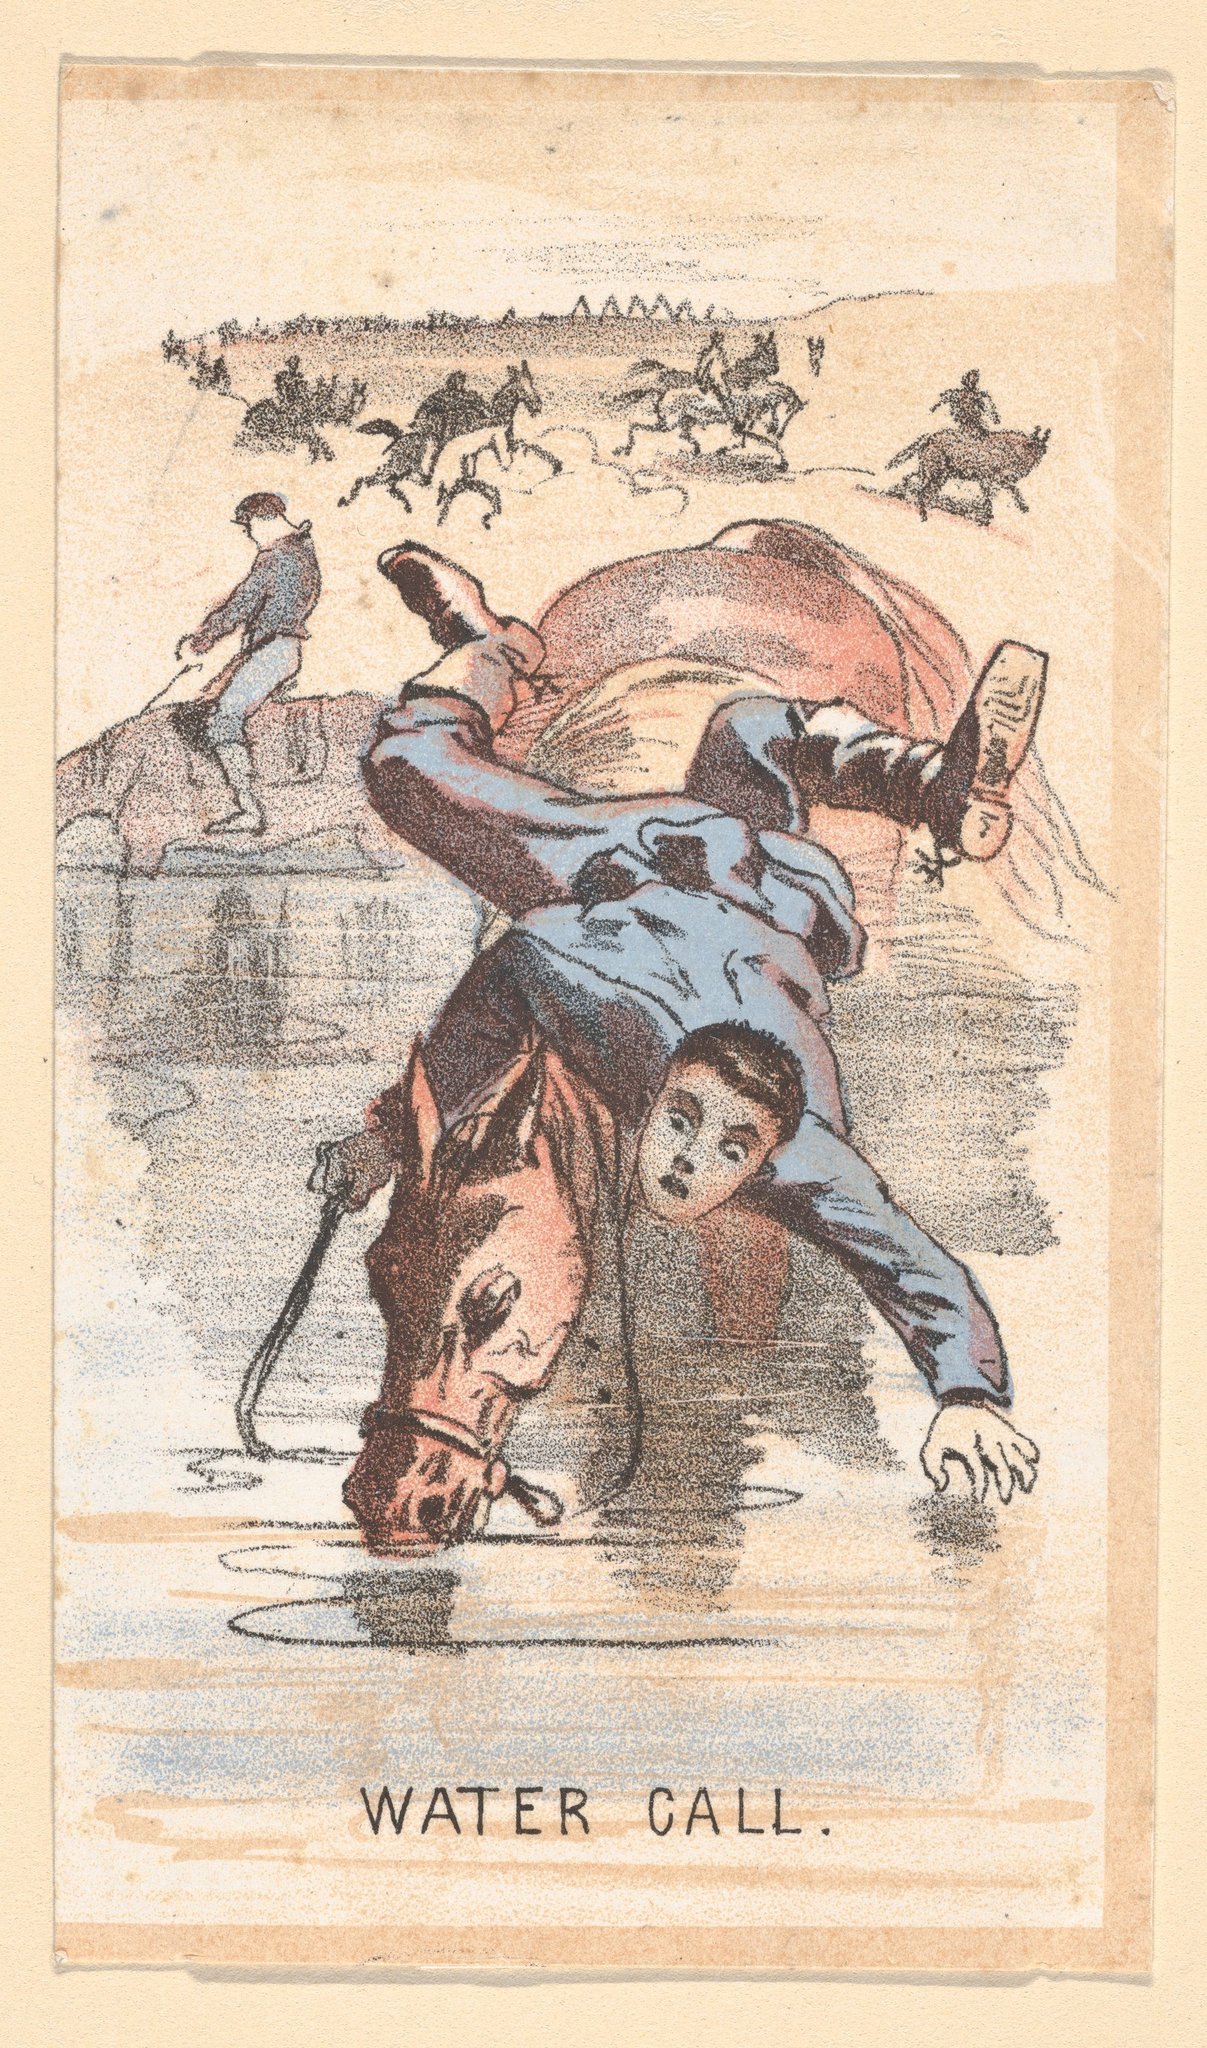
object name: print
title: Life in Camp, Part 1: Water Call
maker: winslow homer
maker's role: artist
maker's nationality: american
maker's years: 1836-1910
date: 1864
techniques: lithograph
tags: soldiers,american civil war,men,horses